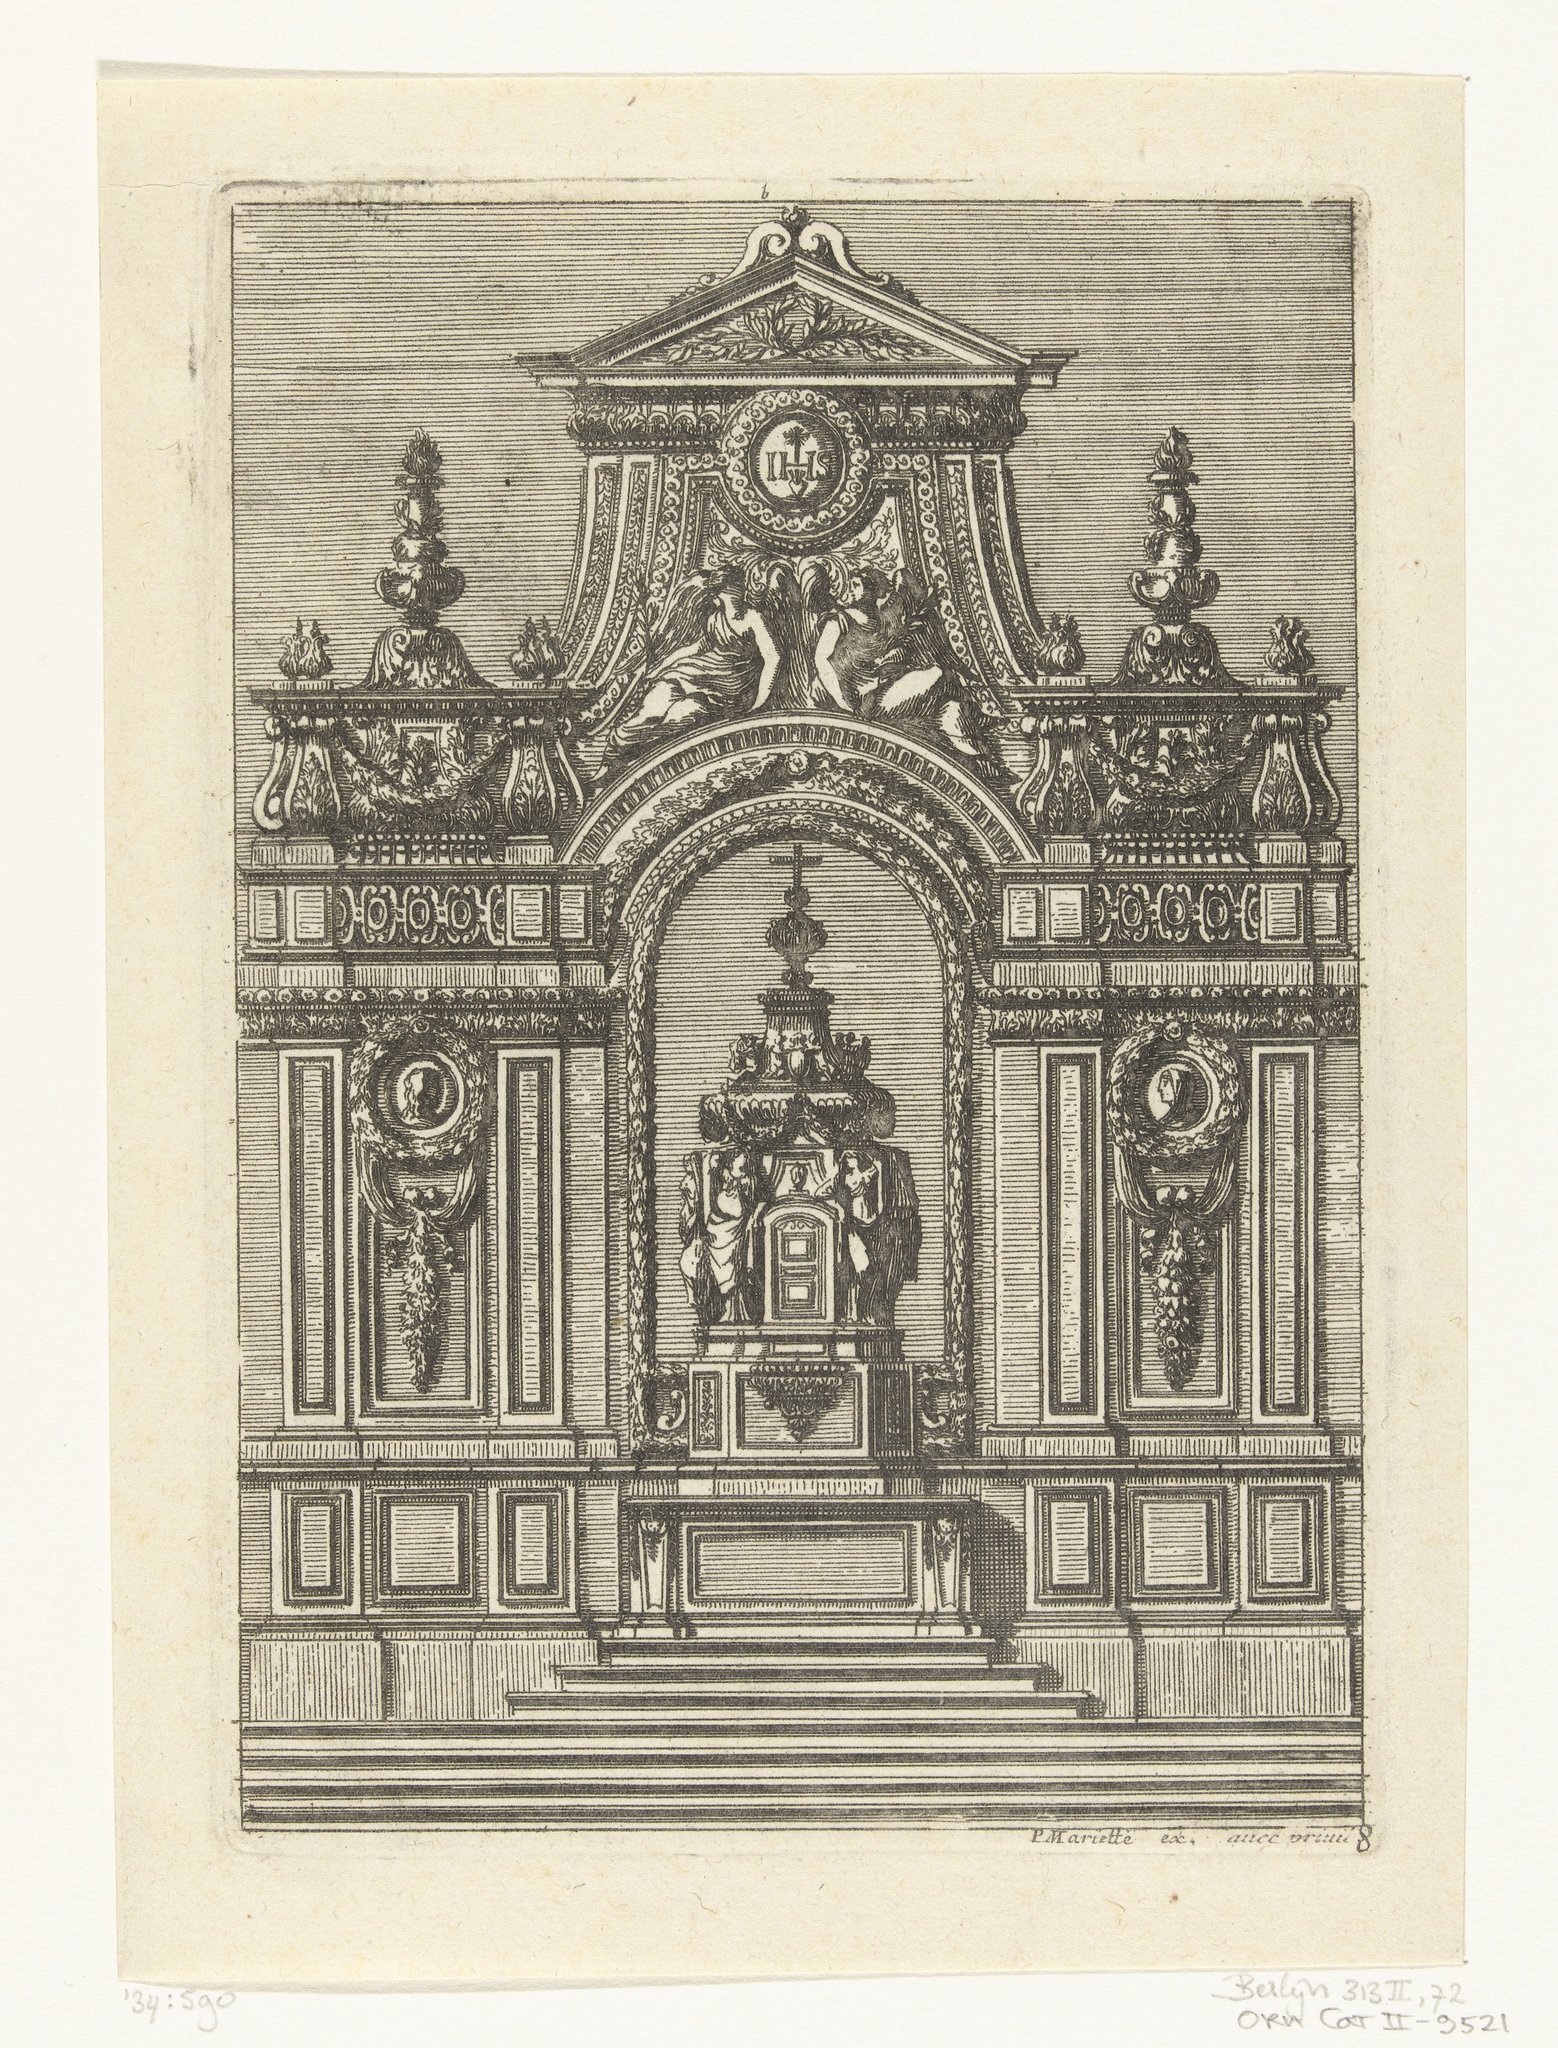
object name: print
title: Authels et Retables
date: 1666-1693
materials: paper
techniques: etching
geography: france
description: Bovenaan staat het monogram van Christus in een medaillon. Midden boven staat de letter b.